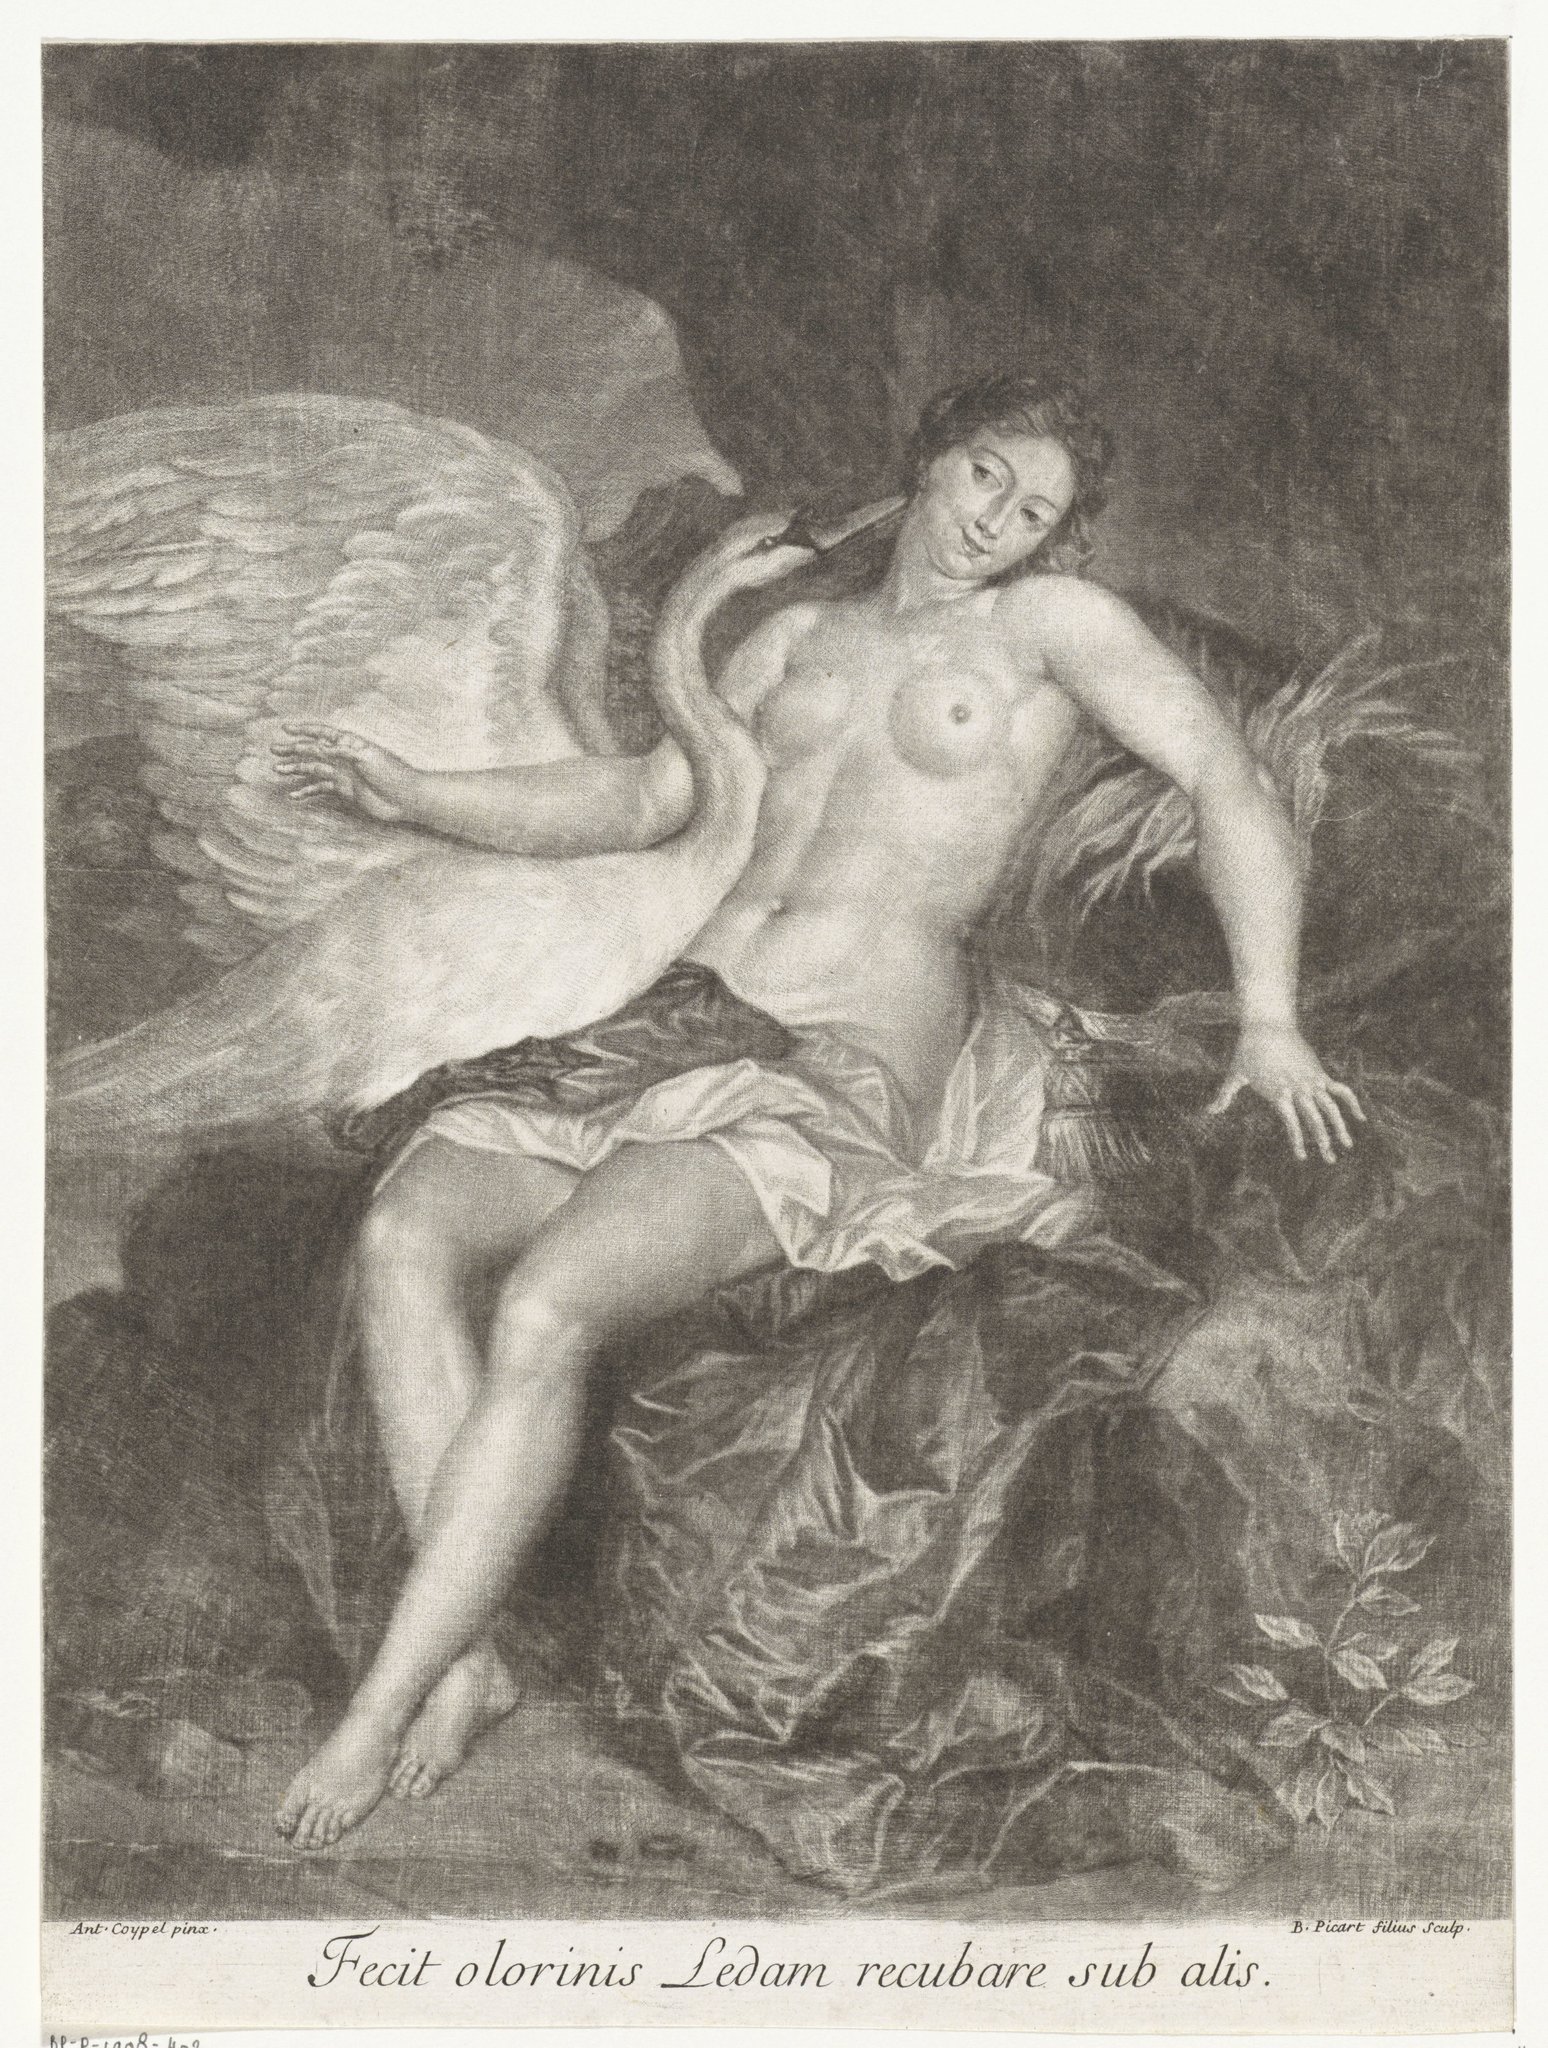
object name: print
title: Fecit olorinis Ledan recubare sub alis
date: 1696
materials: paper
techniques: engraving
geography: paris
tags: jupiter, in the shape of a swan, and leda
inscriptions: collector's mark: Lugt 2228